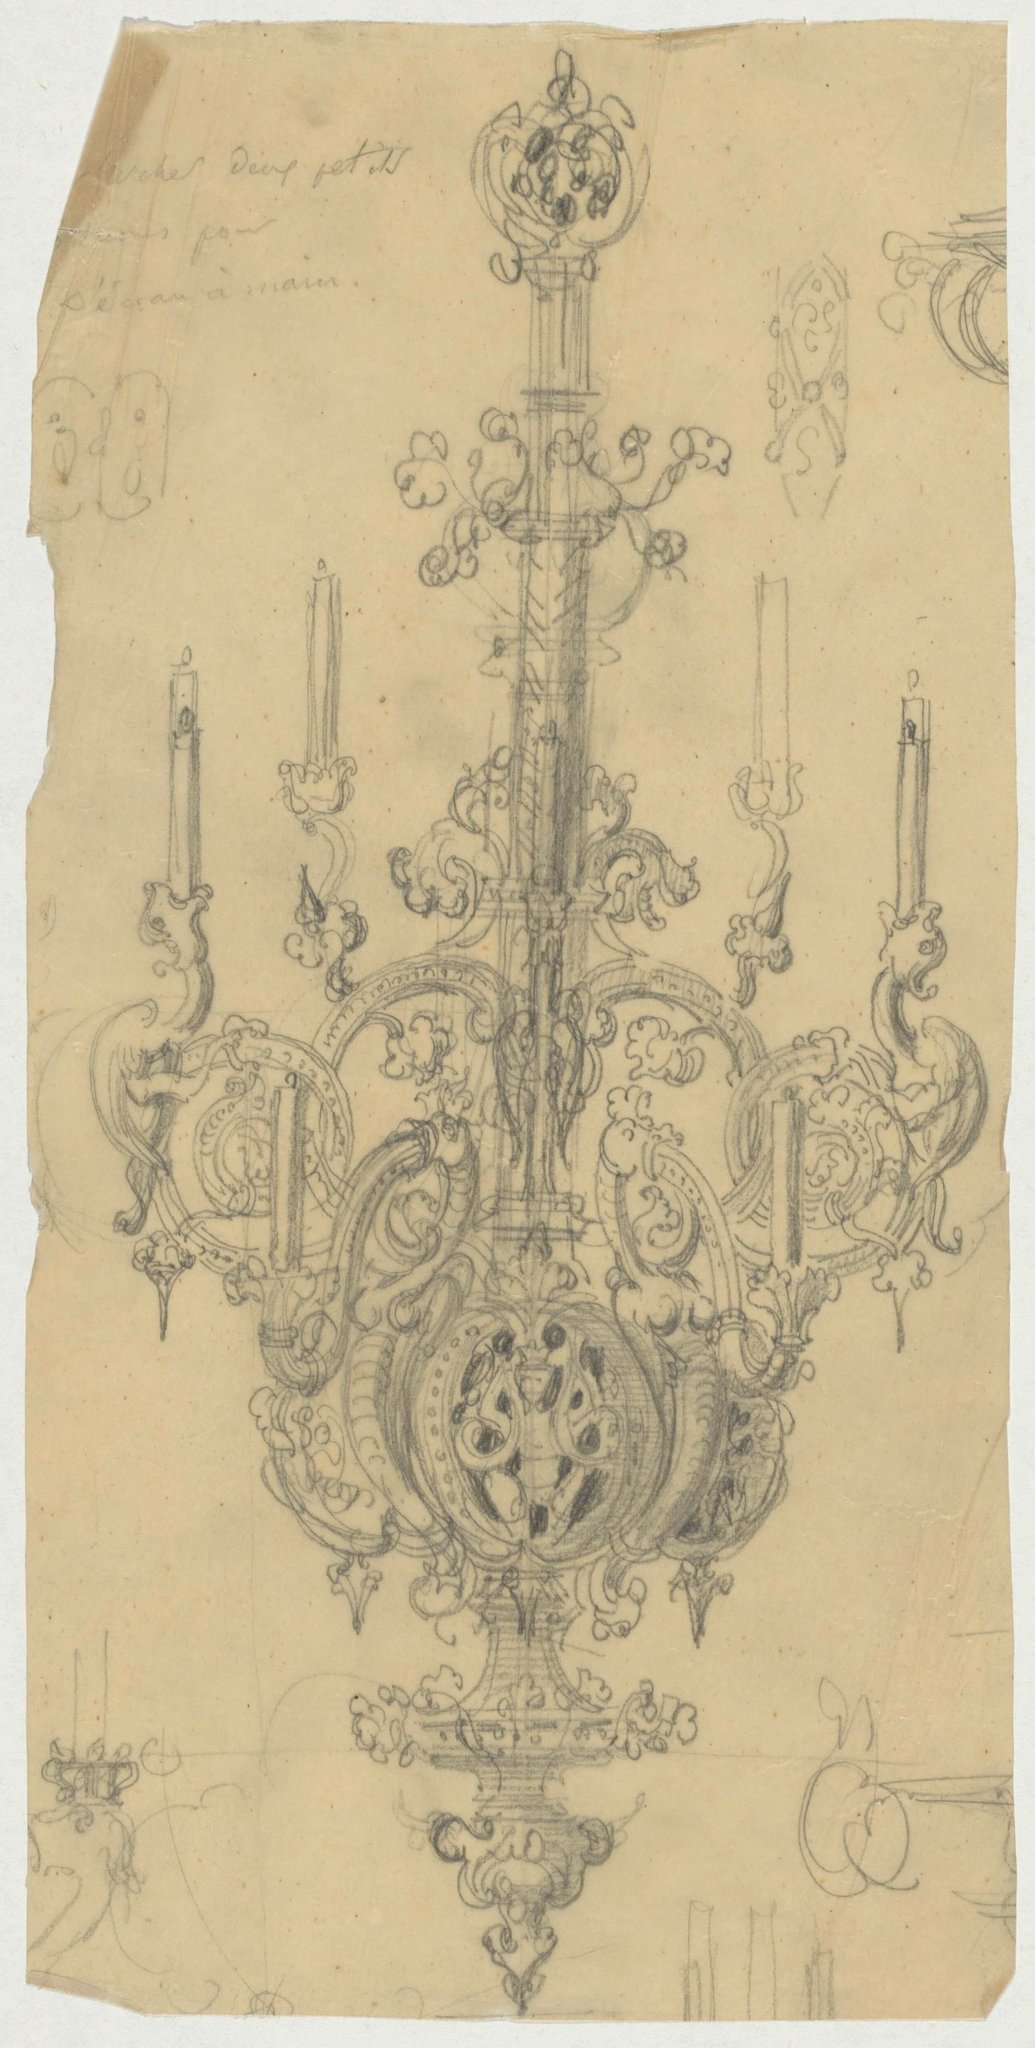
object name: design drawing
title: Hanglamp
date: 1830-1850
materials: graphite, paper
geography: paris